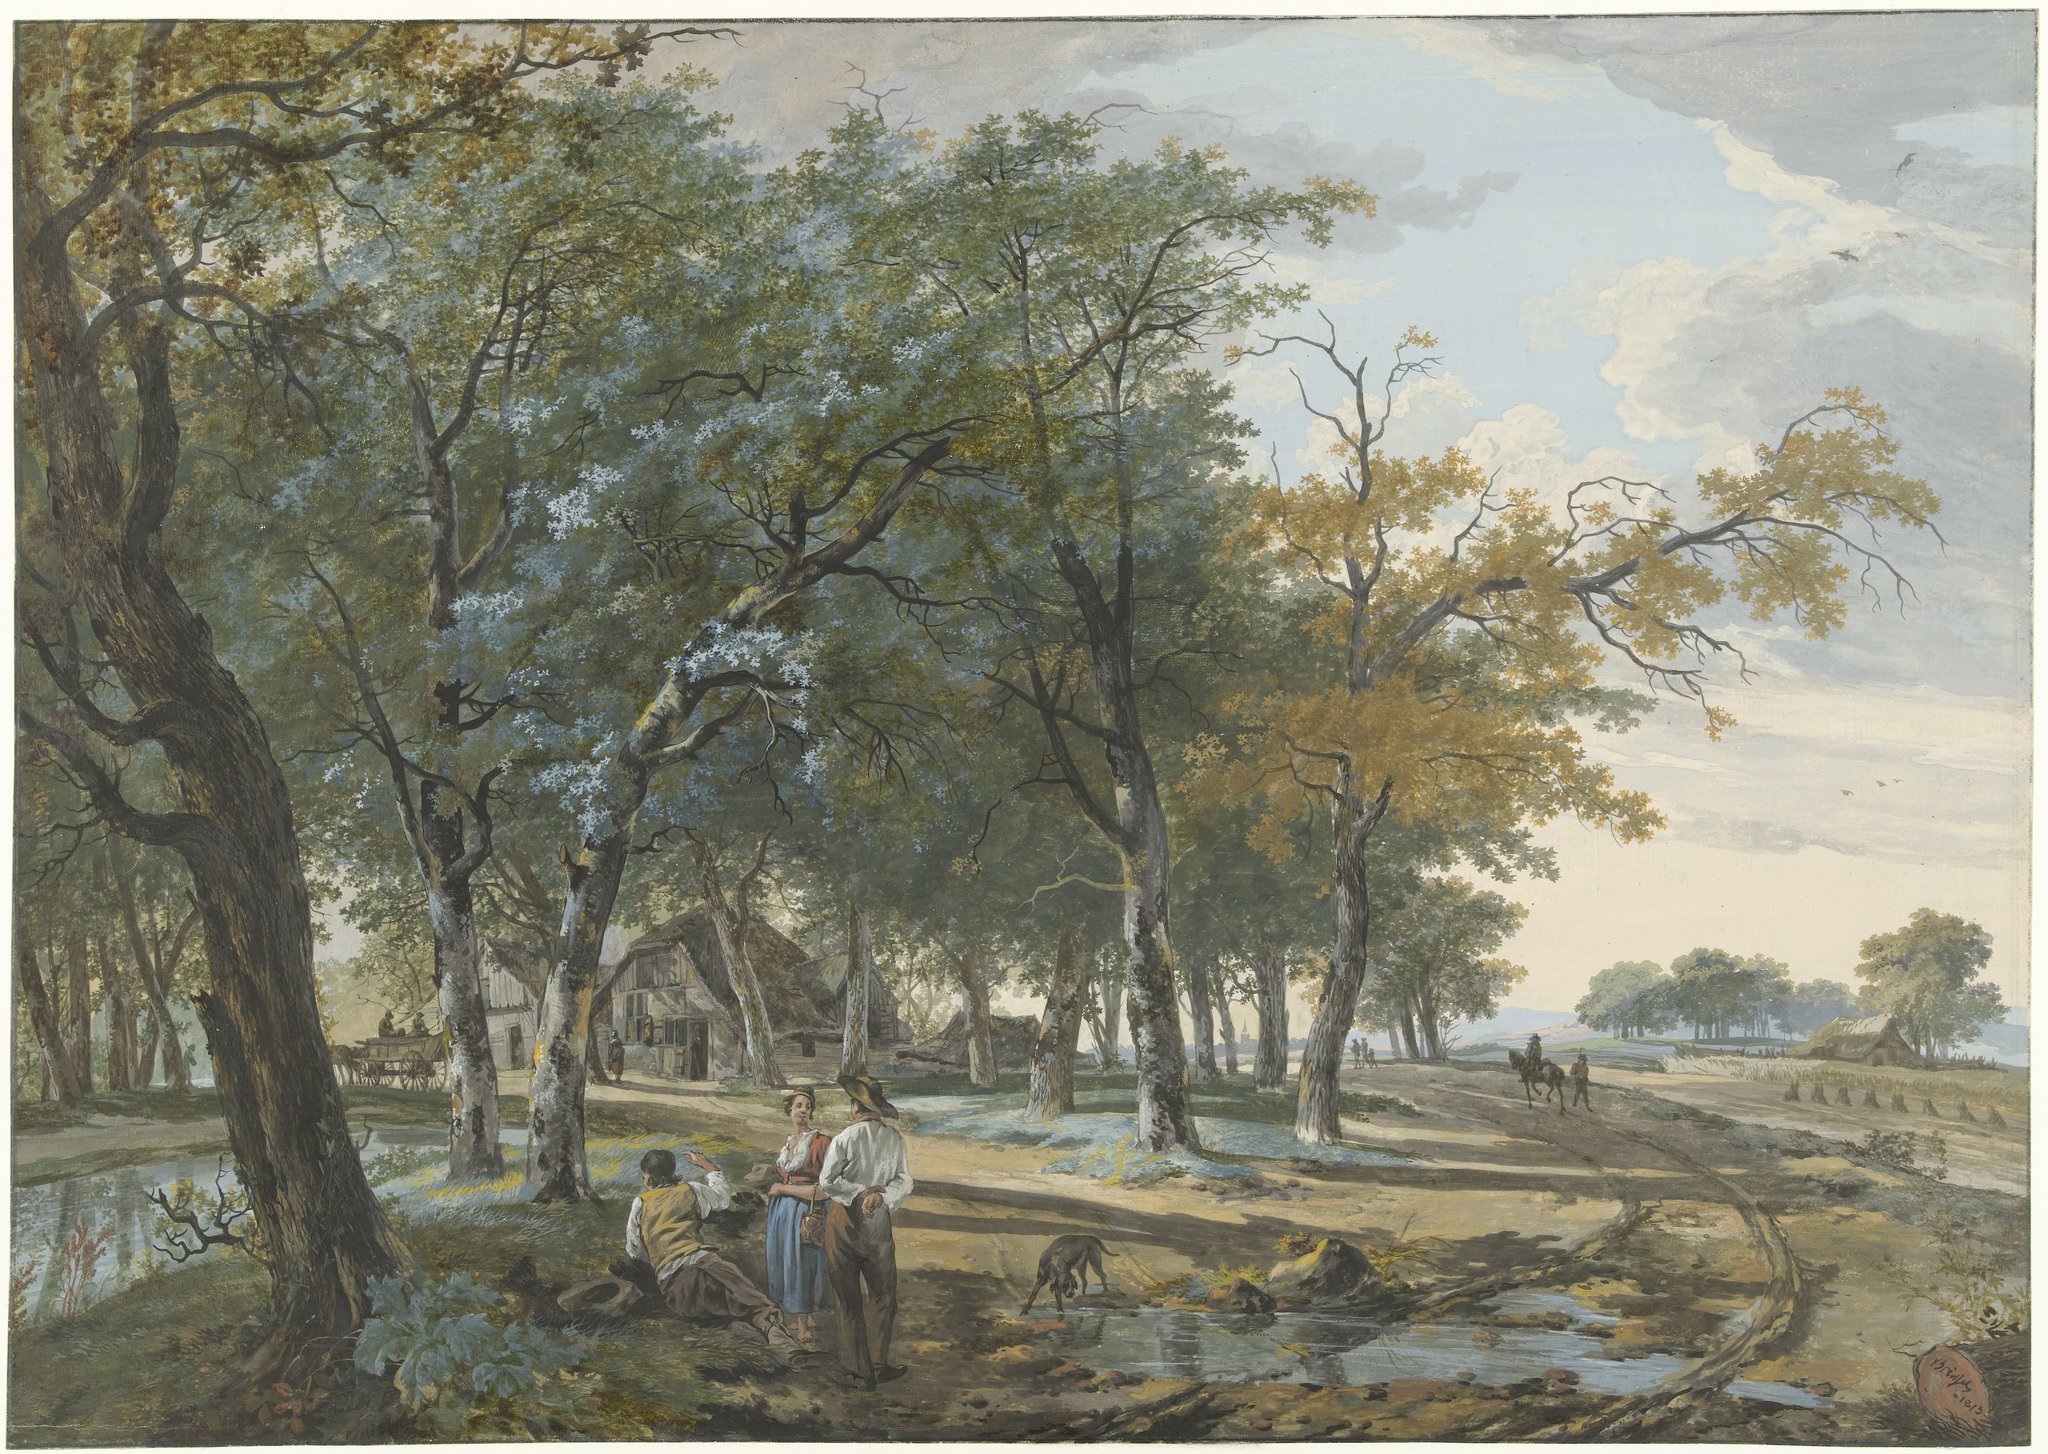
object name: drawing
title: Landschap met een huis tussen bomen en een weg langs akkers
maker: hermanus van brussel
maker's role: draughtsman, print maker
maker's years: 1763-1815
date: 1813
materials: paint, gouache, paper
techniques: brush